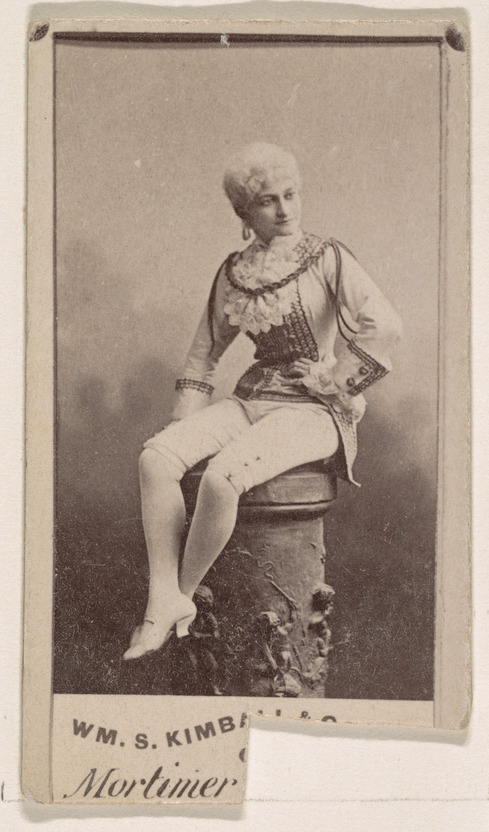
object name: photograph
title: Miss Mortimer, from the Actresses series (N203) issued by Wm. S. Kimball & Co.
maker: william s. kimball & company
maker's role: publisher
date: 1889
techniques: color lithograph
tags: portraits,women,actresses